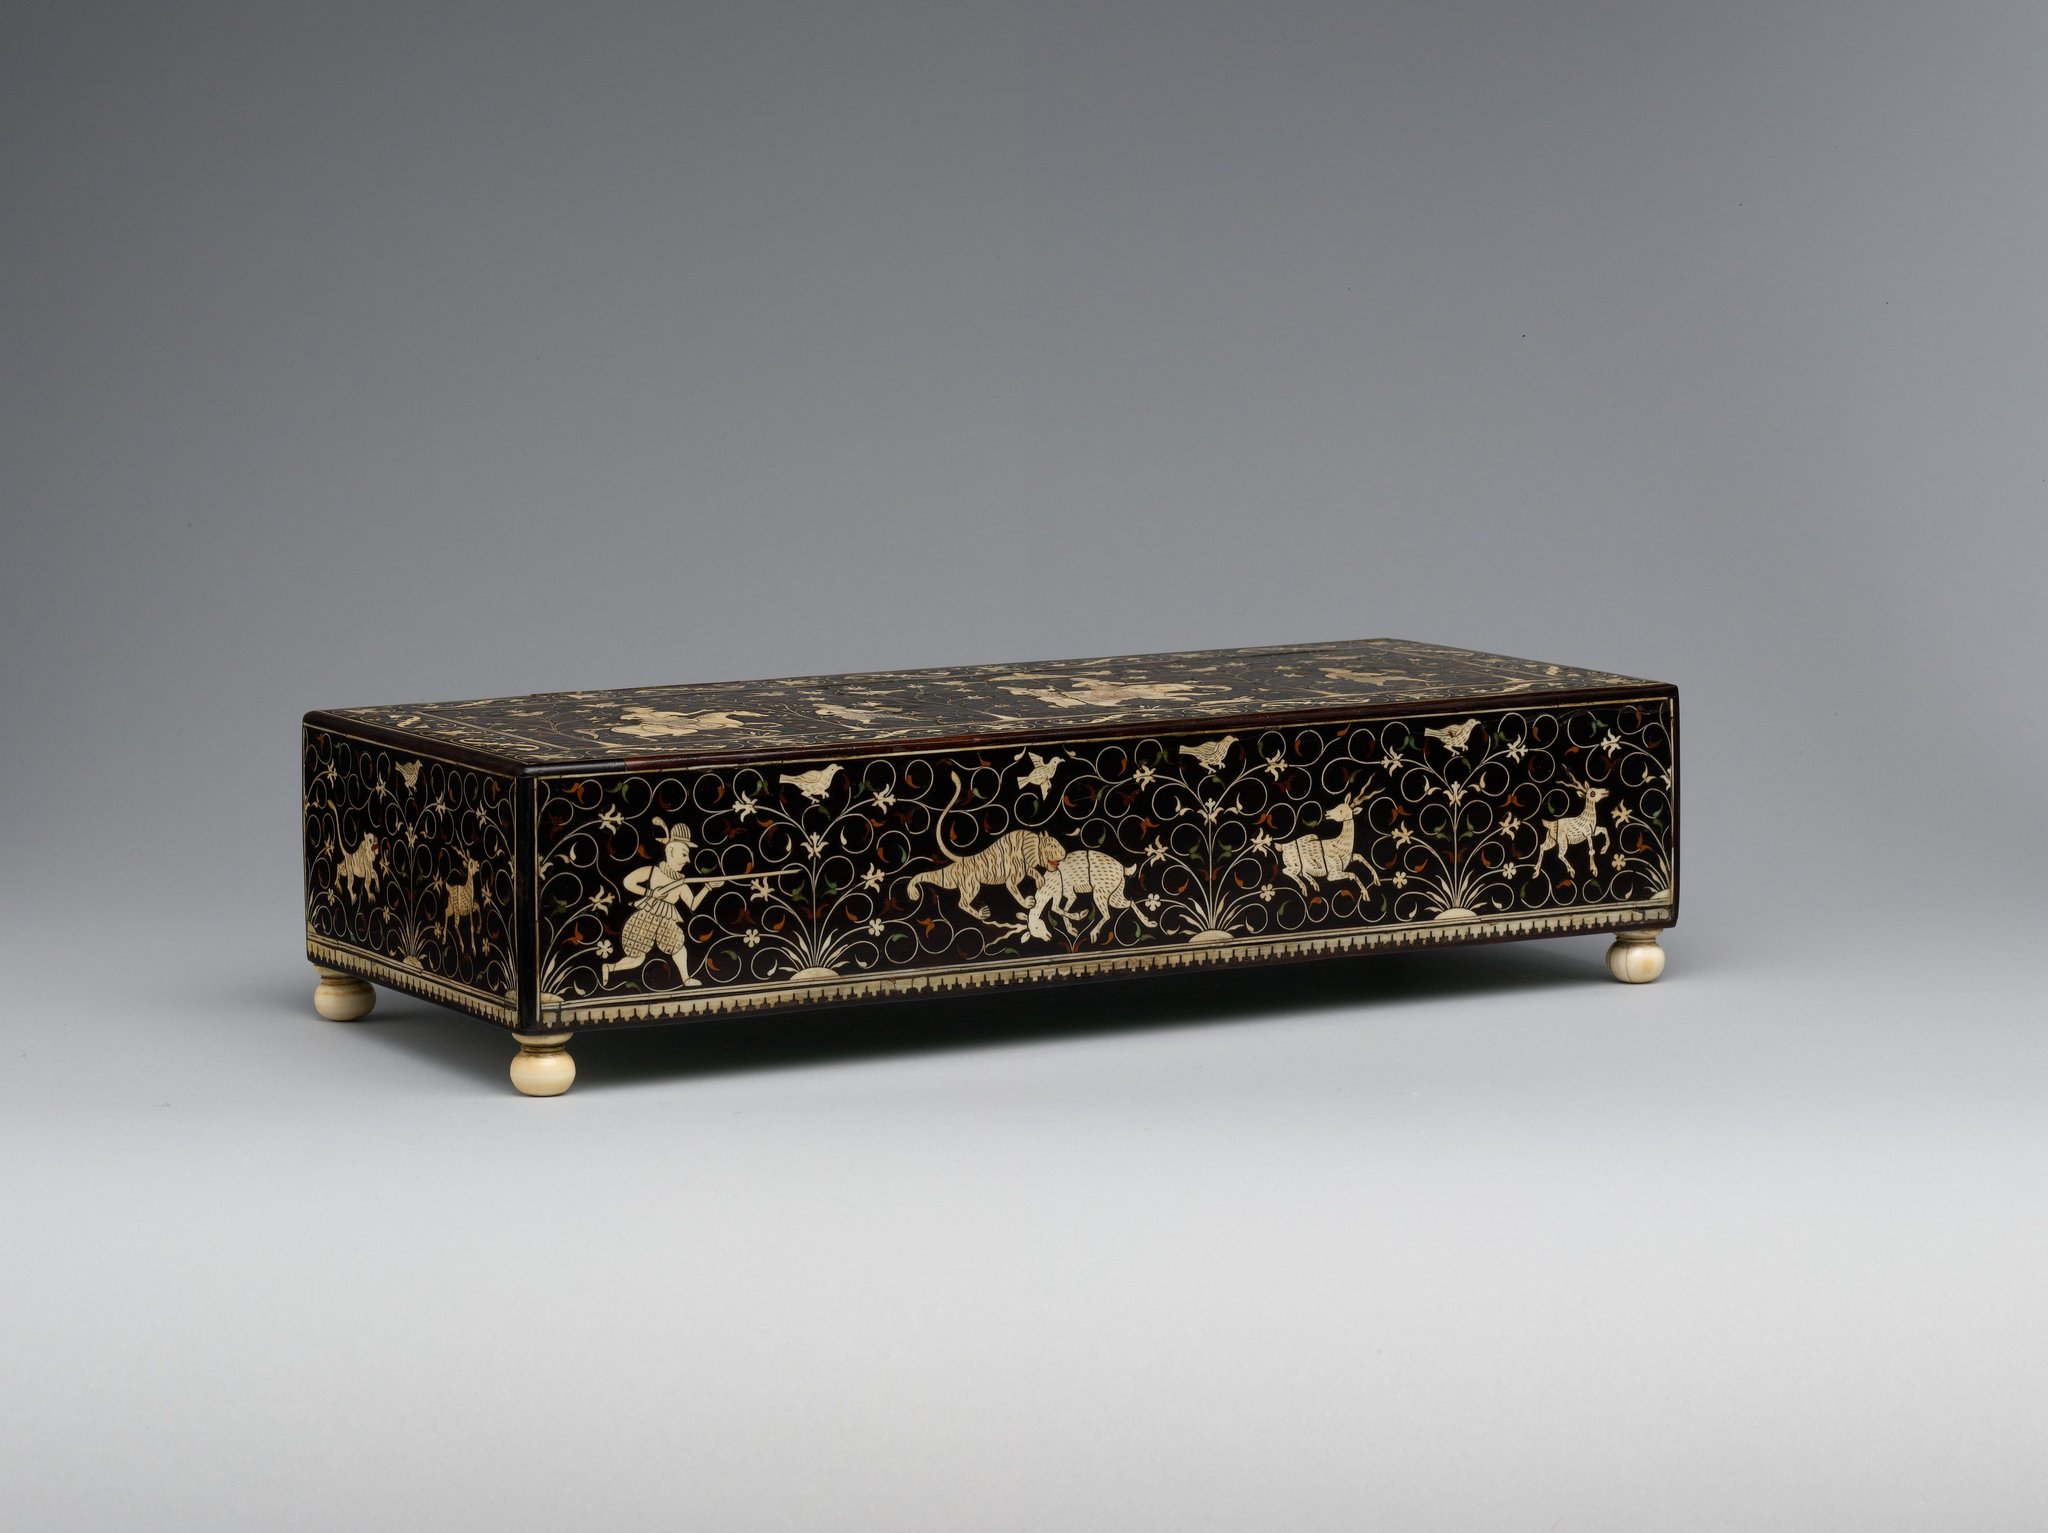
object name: box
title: Inlaid Box for the Portuguese Market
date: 1600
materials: wood, ivory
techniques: inlay, veneering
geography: india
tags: animals,birds,men,hunting,elephants